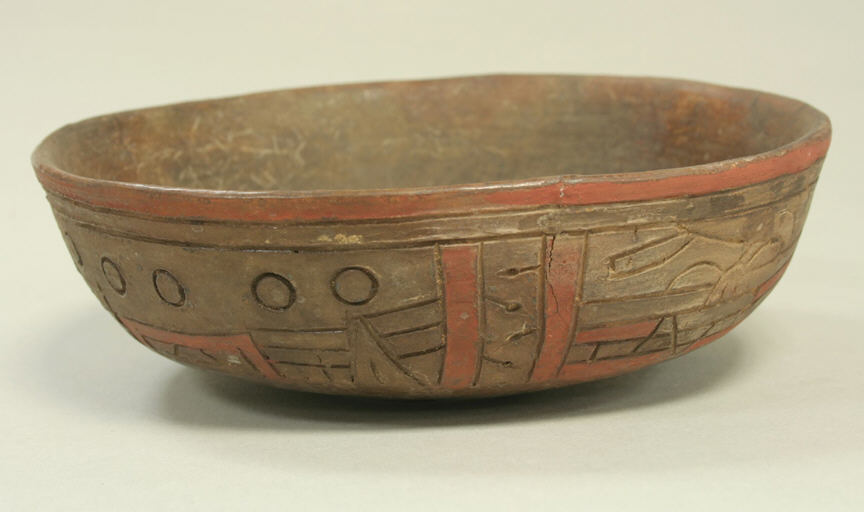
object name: bowl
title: Incised Painted Bowl with Felines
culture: paracas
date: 700-401 BCE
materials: ceramic, pigment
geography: peru